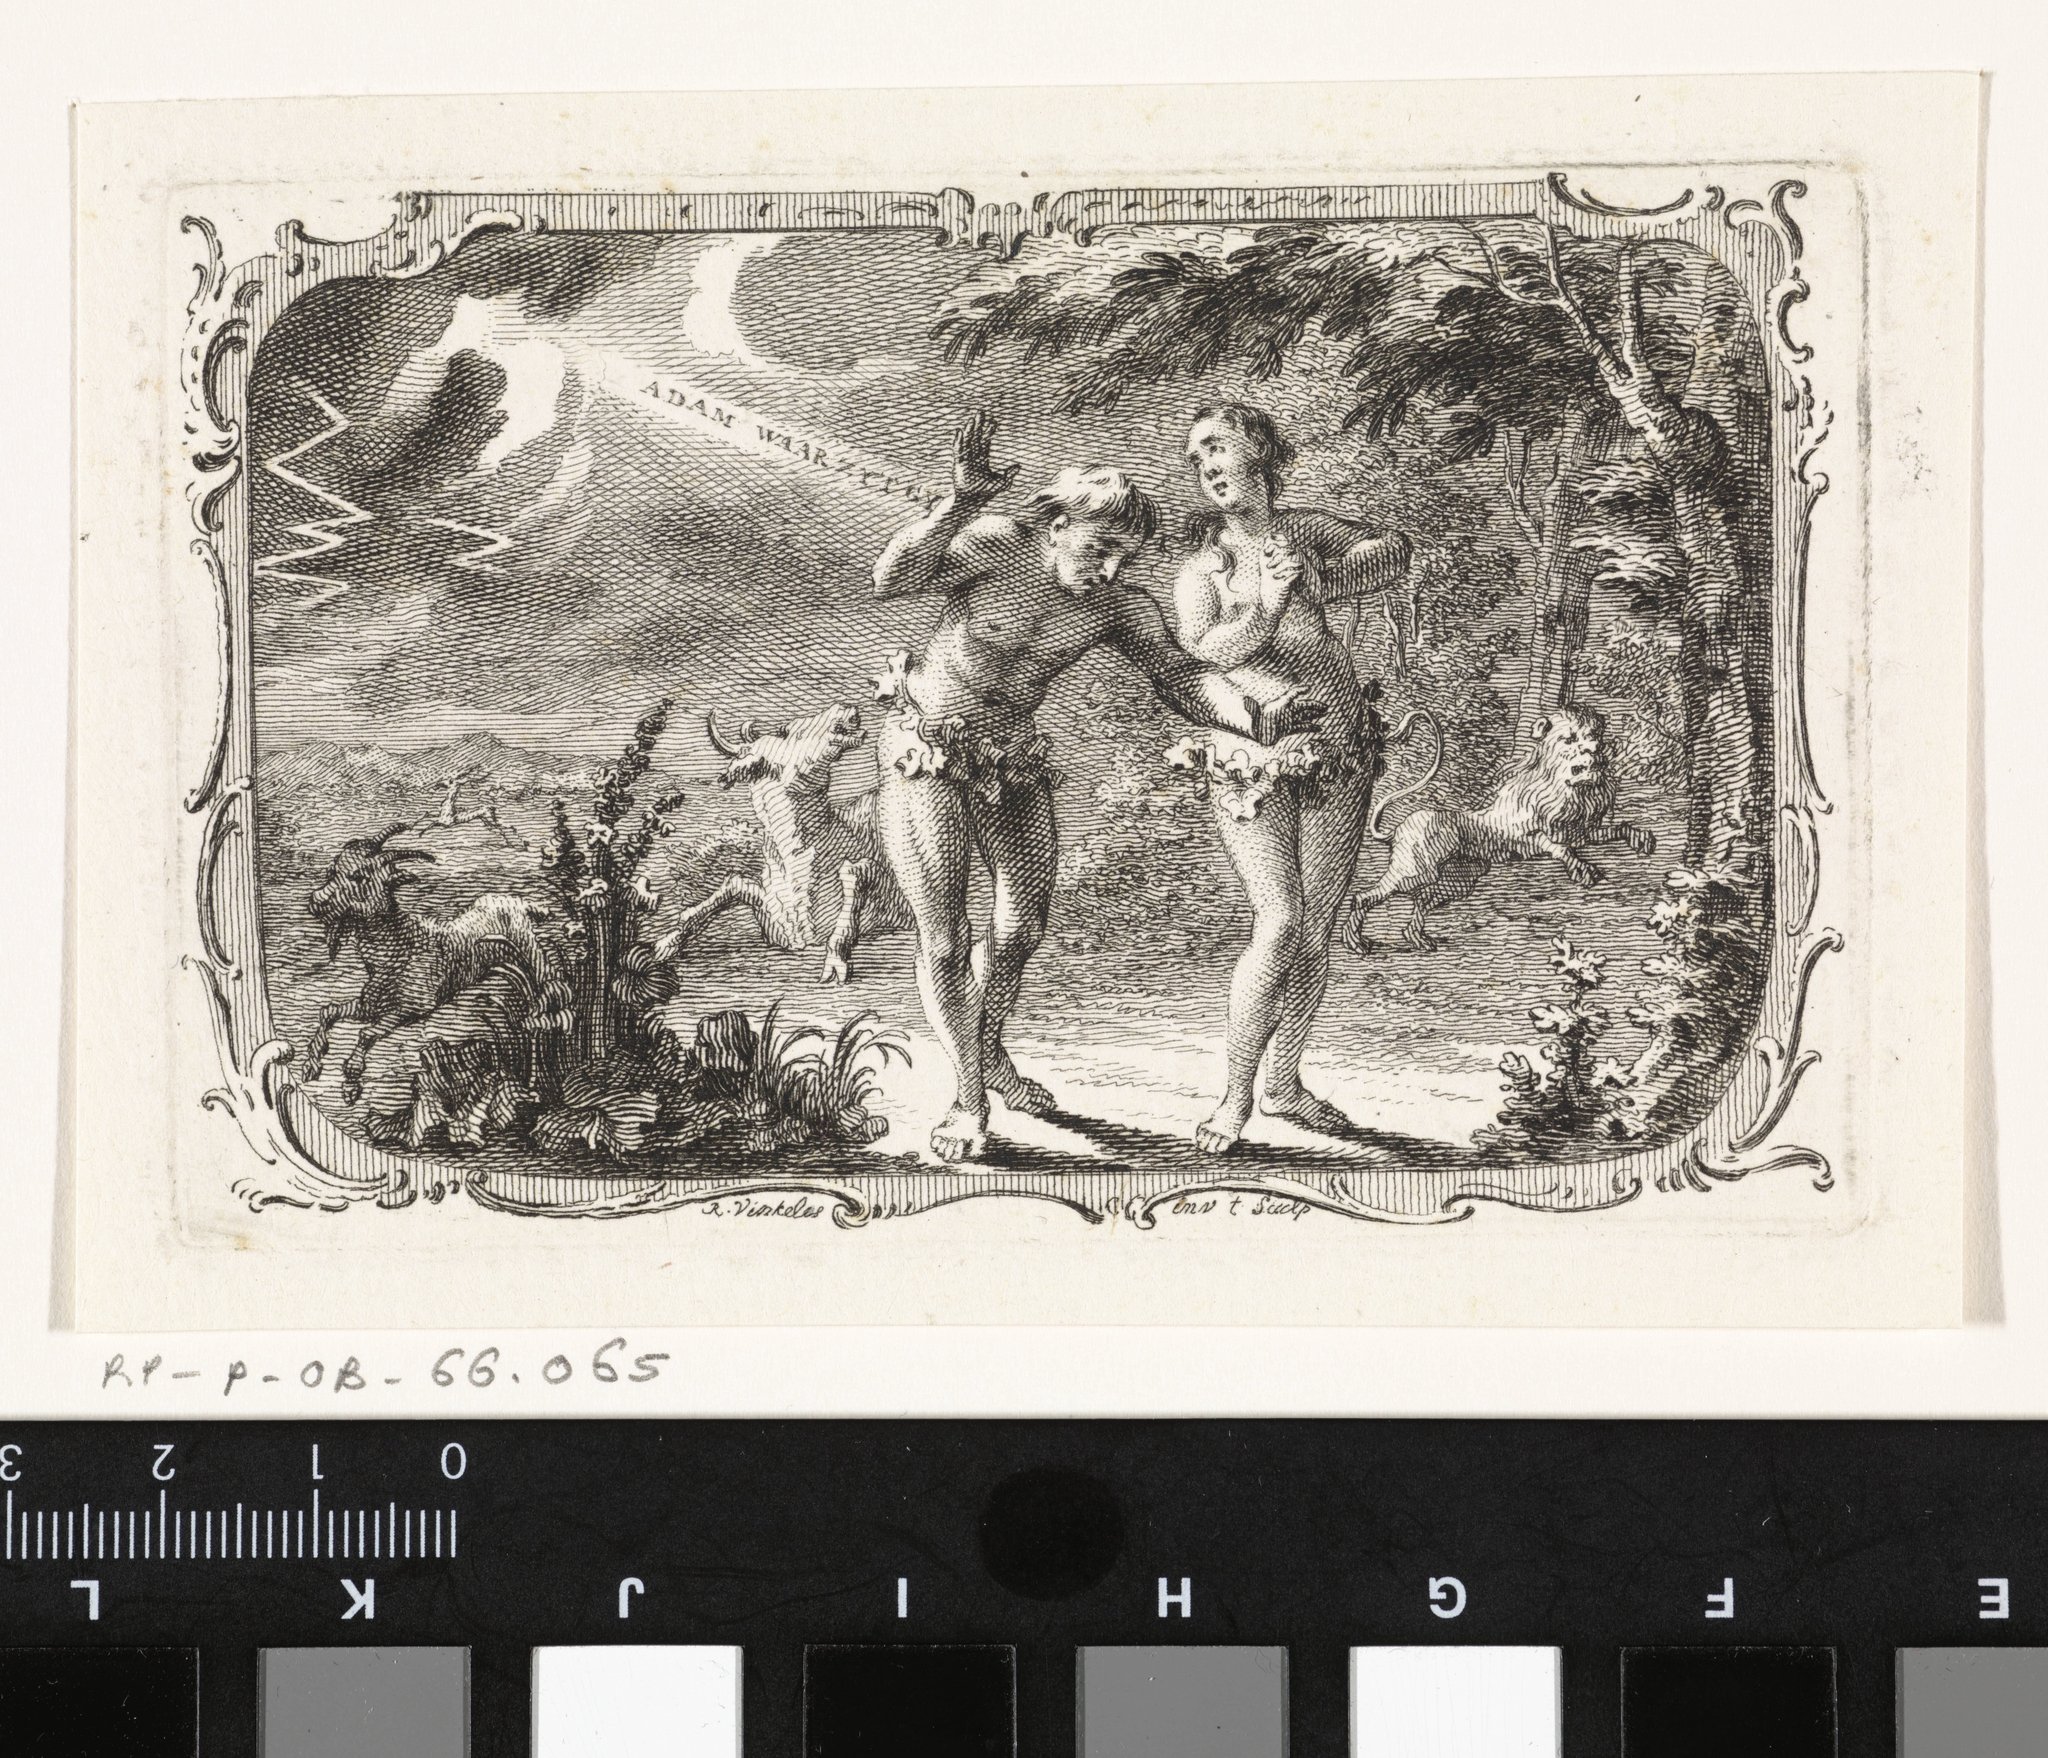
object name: print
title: God roept Adam en Eva ter verantwoording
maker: reinier vinkeles (i)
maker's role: draughtsman, print maker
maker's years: 1741-1816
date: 1751-1816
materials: paper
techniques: engraving, etching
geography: amsterdam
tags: god calls adam and eve to account for their deed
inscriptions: collector's mark: Lugt 240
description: God roept Adam en Eva in het Paradijs ter verantwoording, nadat zij gegeten hebben van de boom van kennis van goed en kwaad. Illustratie van de Bijbeltekst Gen. 3: 9.